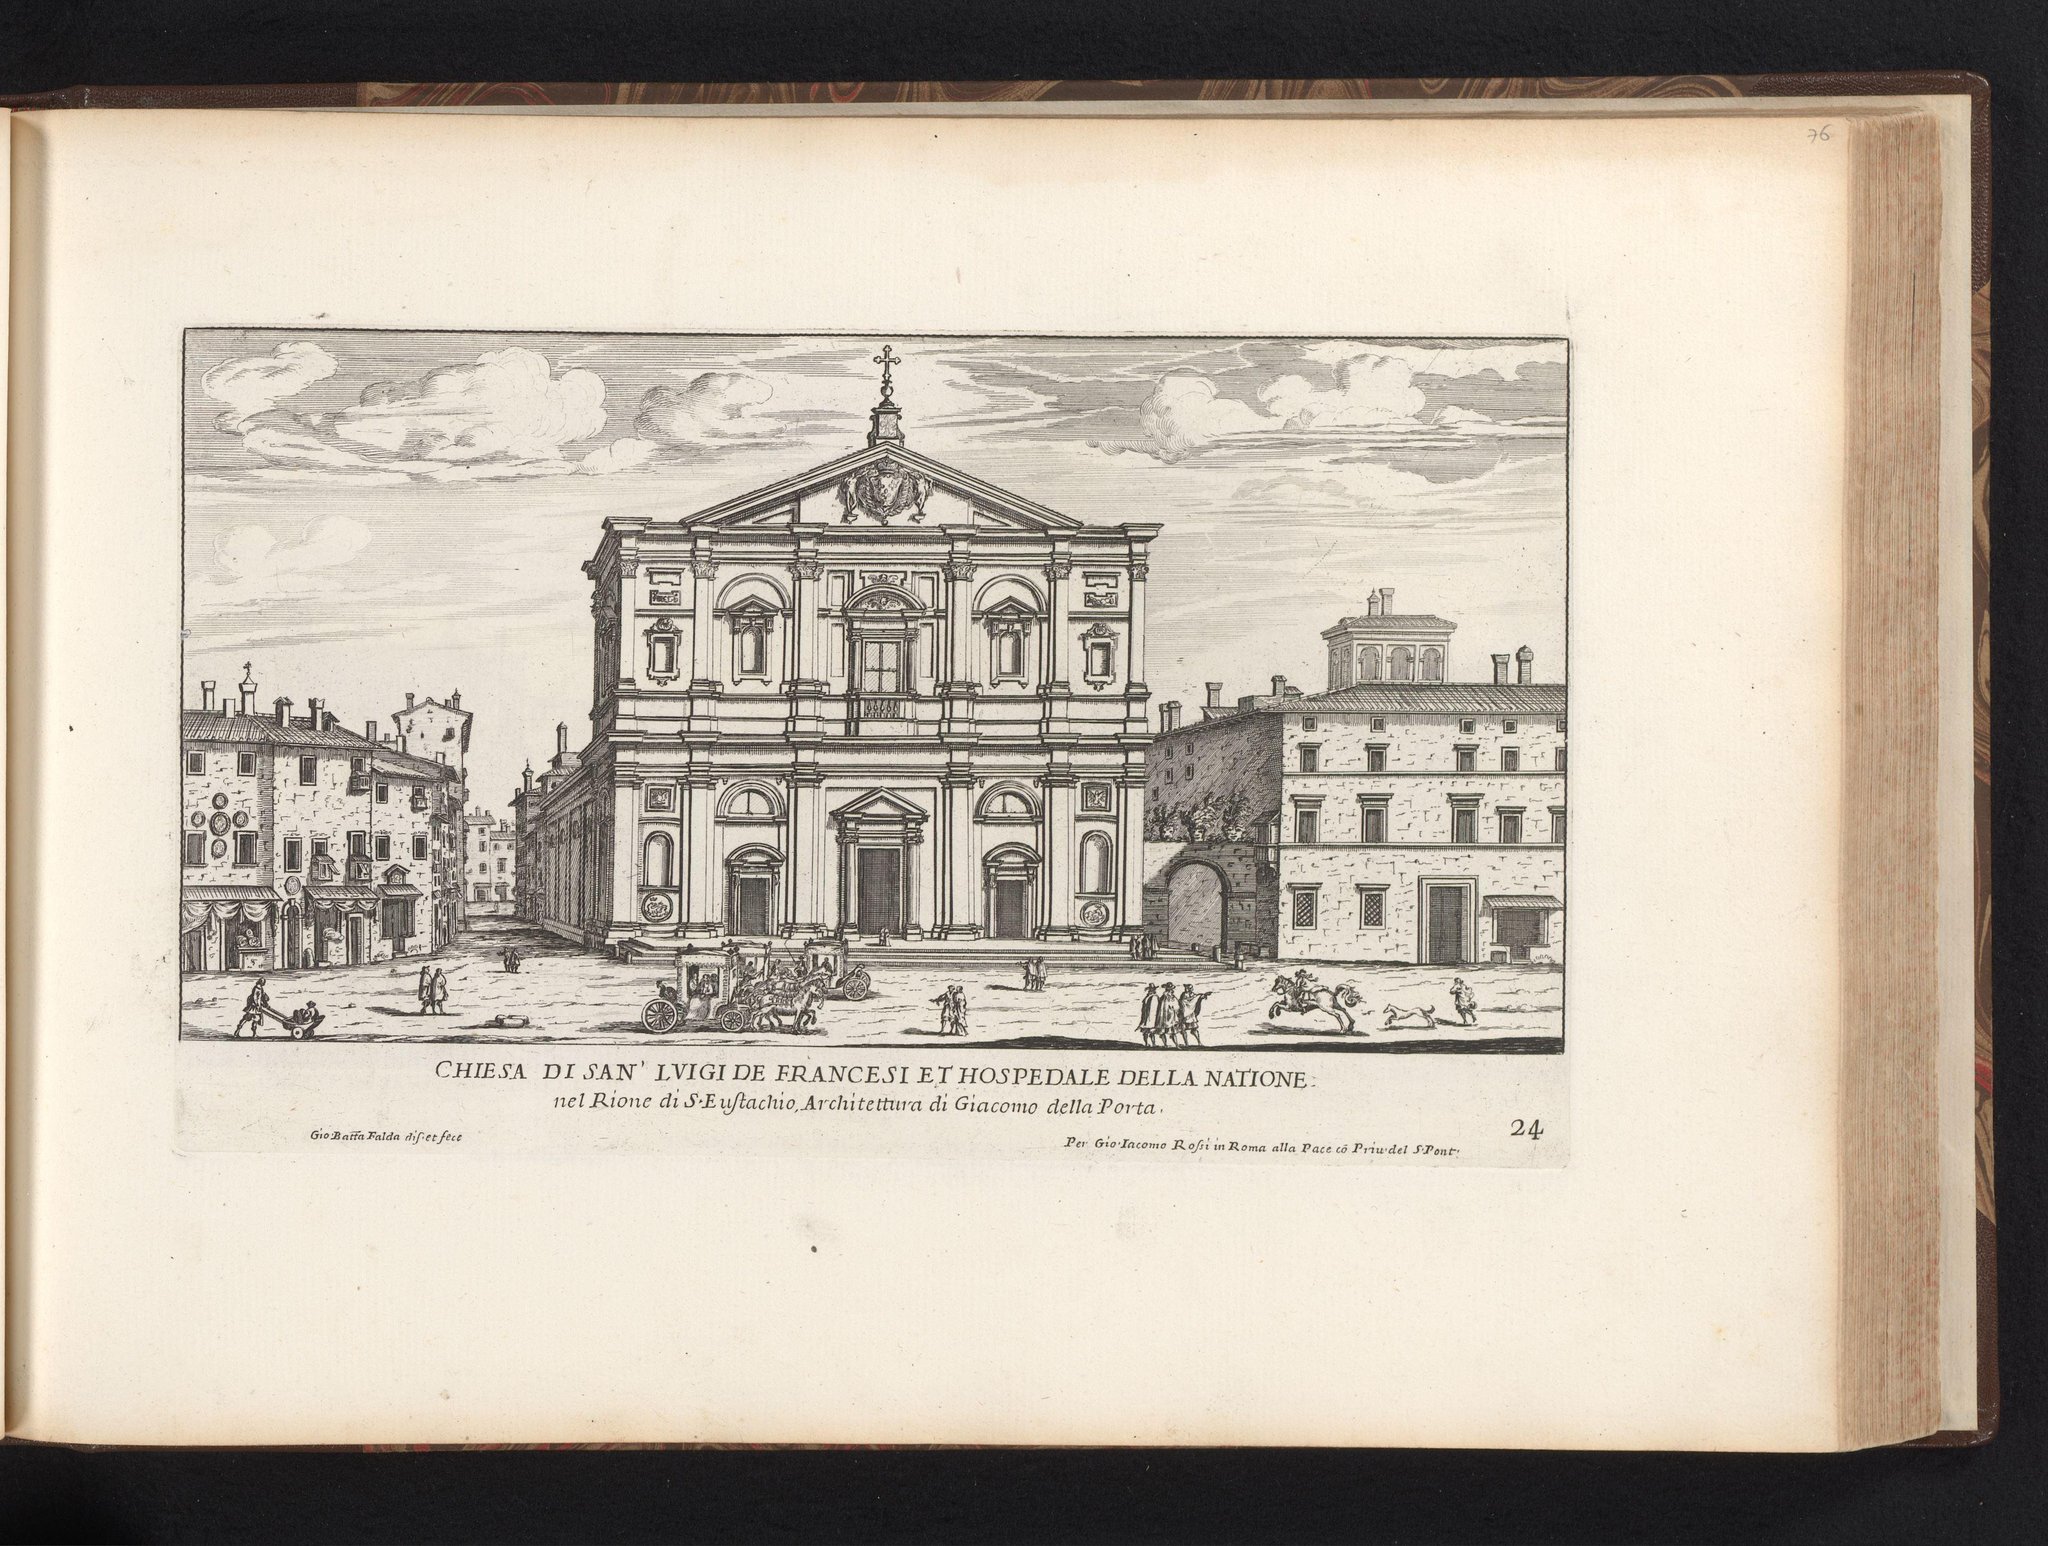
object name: print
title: Chiesa di San' Luigi de Francesi et hospedale della nation (...)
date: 1669-1670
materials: paper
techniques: etching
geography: rome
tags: city-view, and landscape with man-made constructions, church (exterior)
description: Deze titelprent maakt deel uit van een reeks van 38 prenten met voorstellingen van kerken in Rome. Samen met vier andere reeksen vormt het de grote reeks: 'Il nuovo teatro di Roma moderna'.